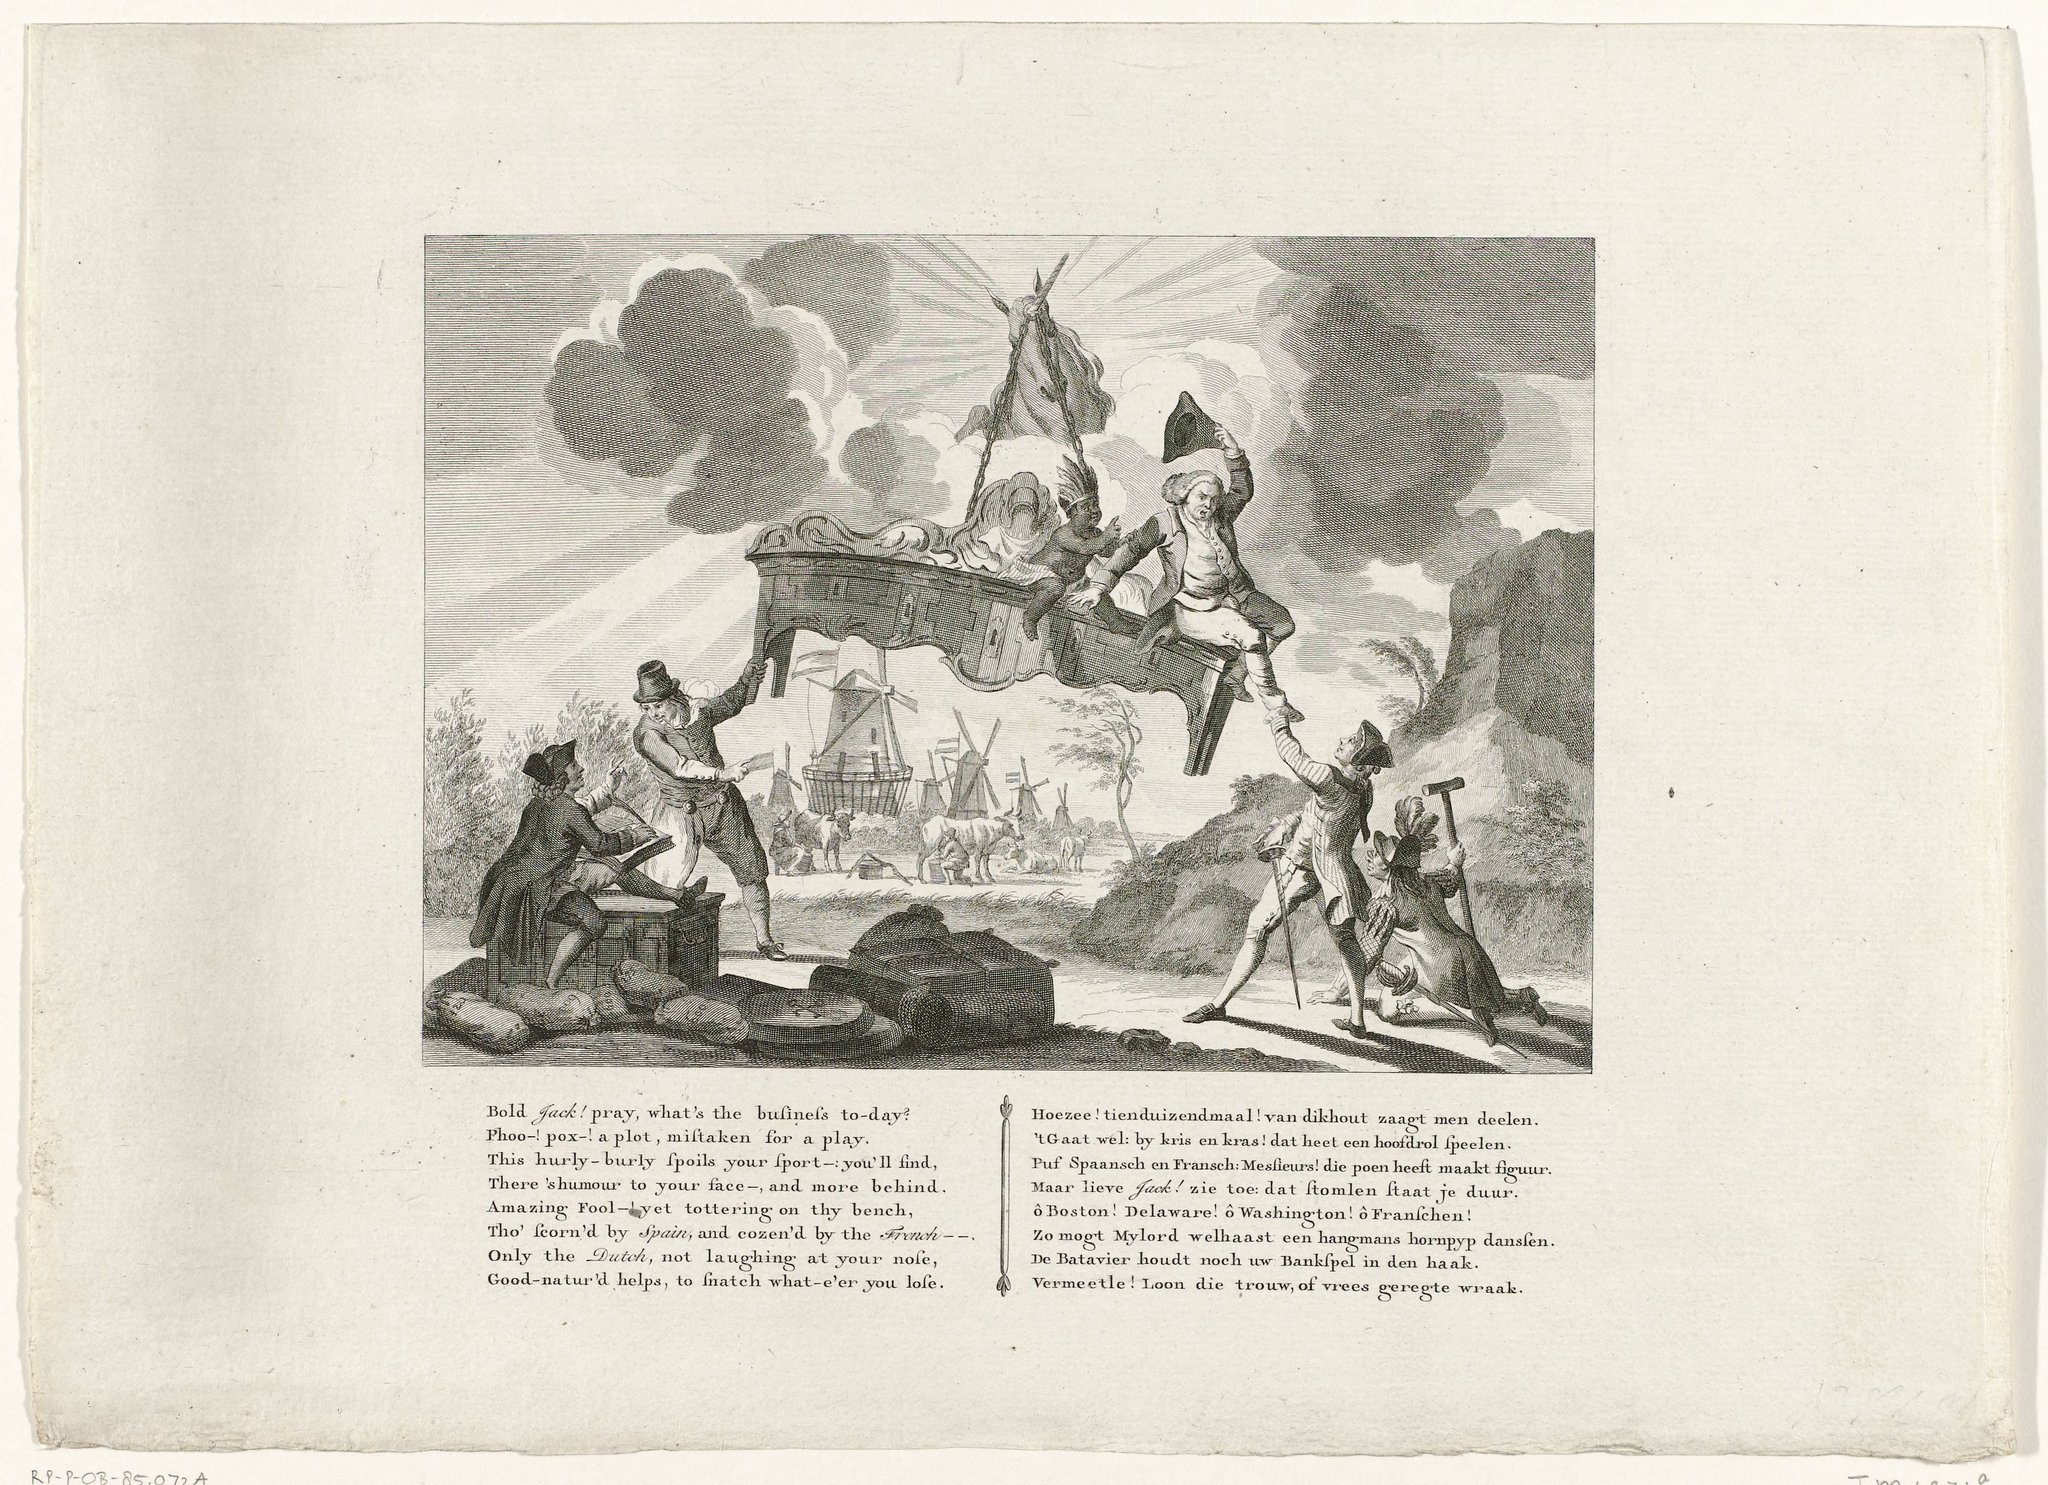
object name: print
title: Spotprent op de wankele Britse economische positie, ca. 1780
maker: Anonymous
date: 1780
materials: paper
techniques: engraving, etching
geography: northern netherlands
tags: indigenous peoples of north america, political caricatures and satires, fourth anglo-dutch war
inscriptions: collector's mark: Lugt 2228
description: Spotprent op de wankele toestand van de Britse economie in 1780. De Britse wisselbank hangt aan de hoorn van een eenhoorn in de wolken en wordt verder alleen nog door de (Engelsgezinde) Hollandse koopvaardij in de lucht gehouden, rechts trekt een Fransman de Engelsman van de bank af, hiertoe aangespoord door de Spanjaard en geholpen door een oorspronkelijke Amerikaan. In de verte Hollands welvaren in windmolens en melkvee. Onder de voorstelling twee verzen in het Engels en Nederlands. Bij de prent behoort een afzonderlijk gedrukte uitleg.